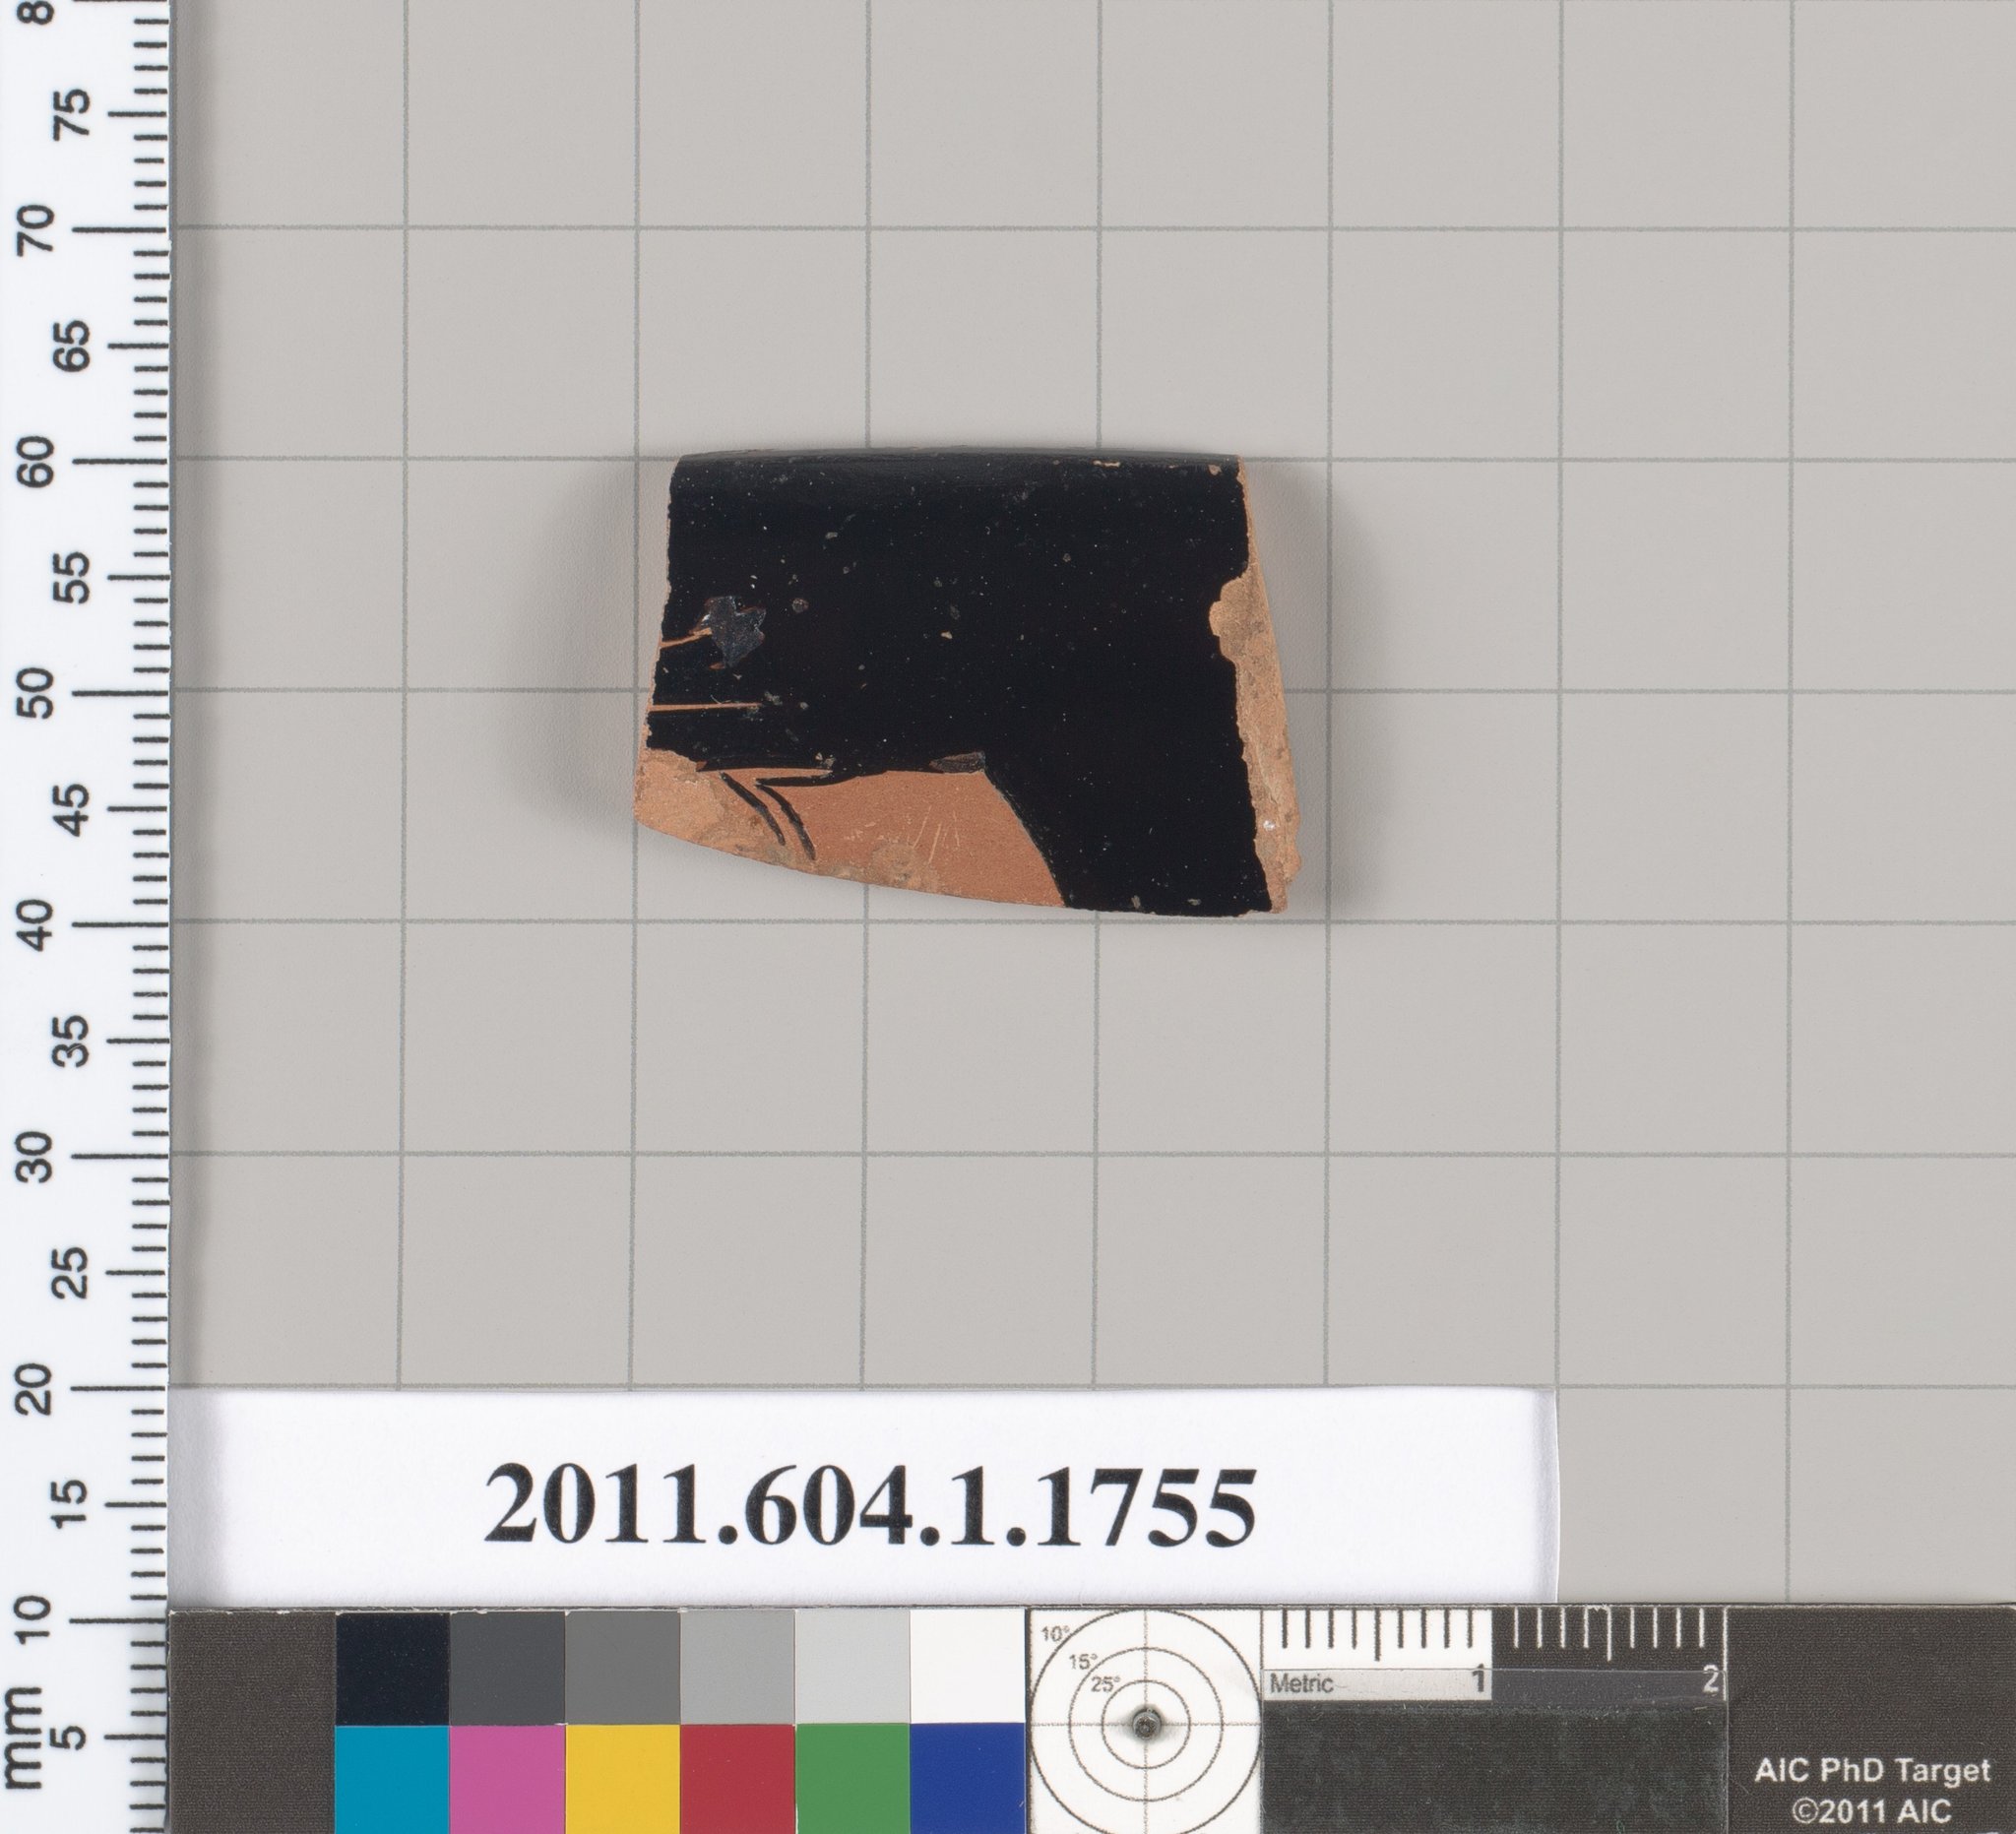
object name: kylix fragment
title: Terracotta rim fragment of a kylix (drinking cup)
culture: greek, attic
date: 475-451 BCE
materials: terracotta